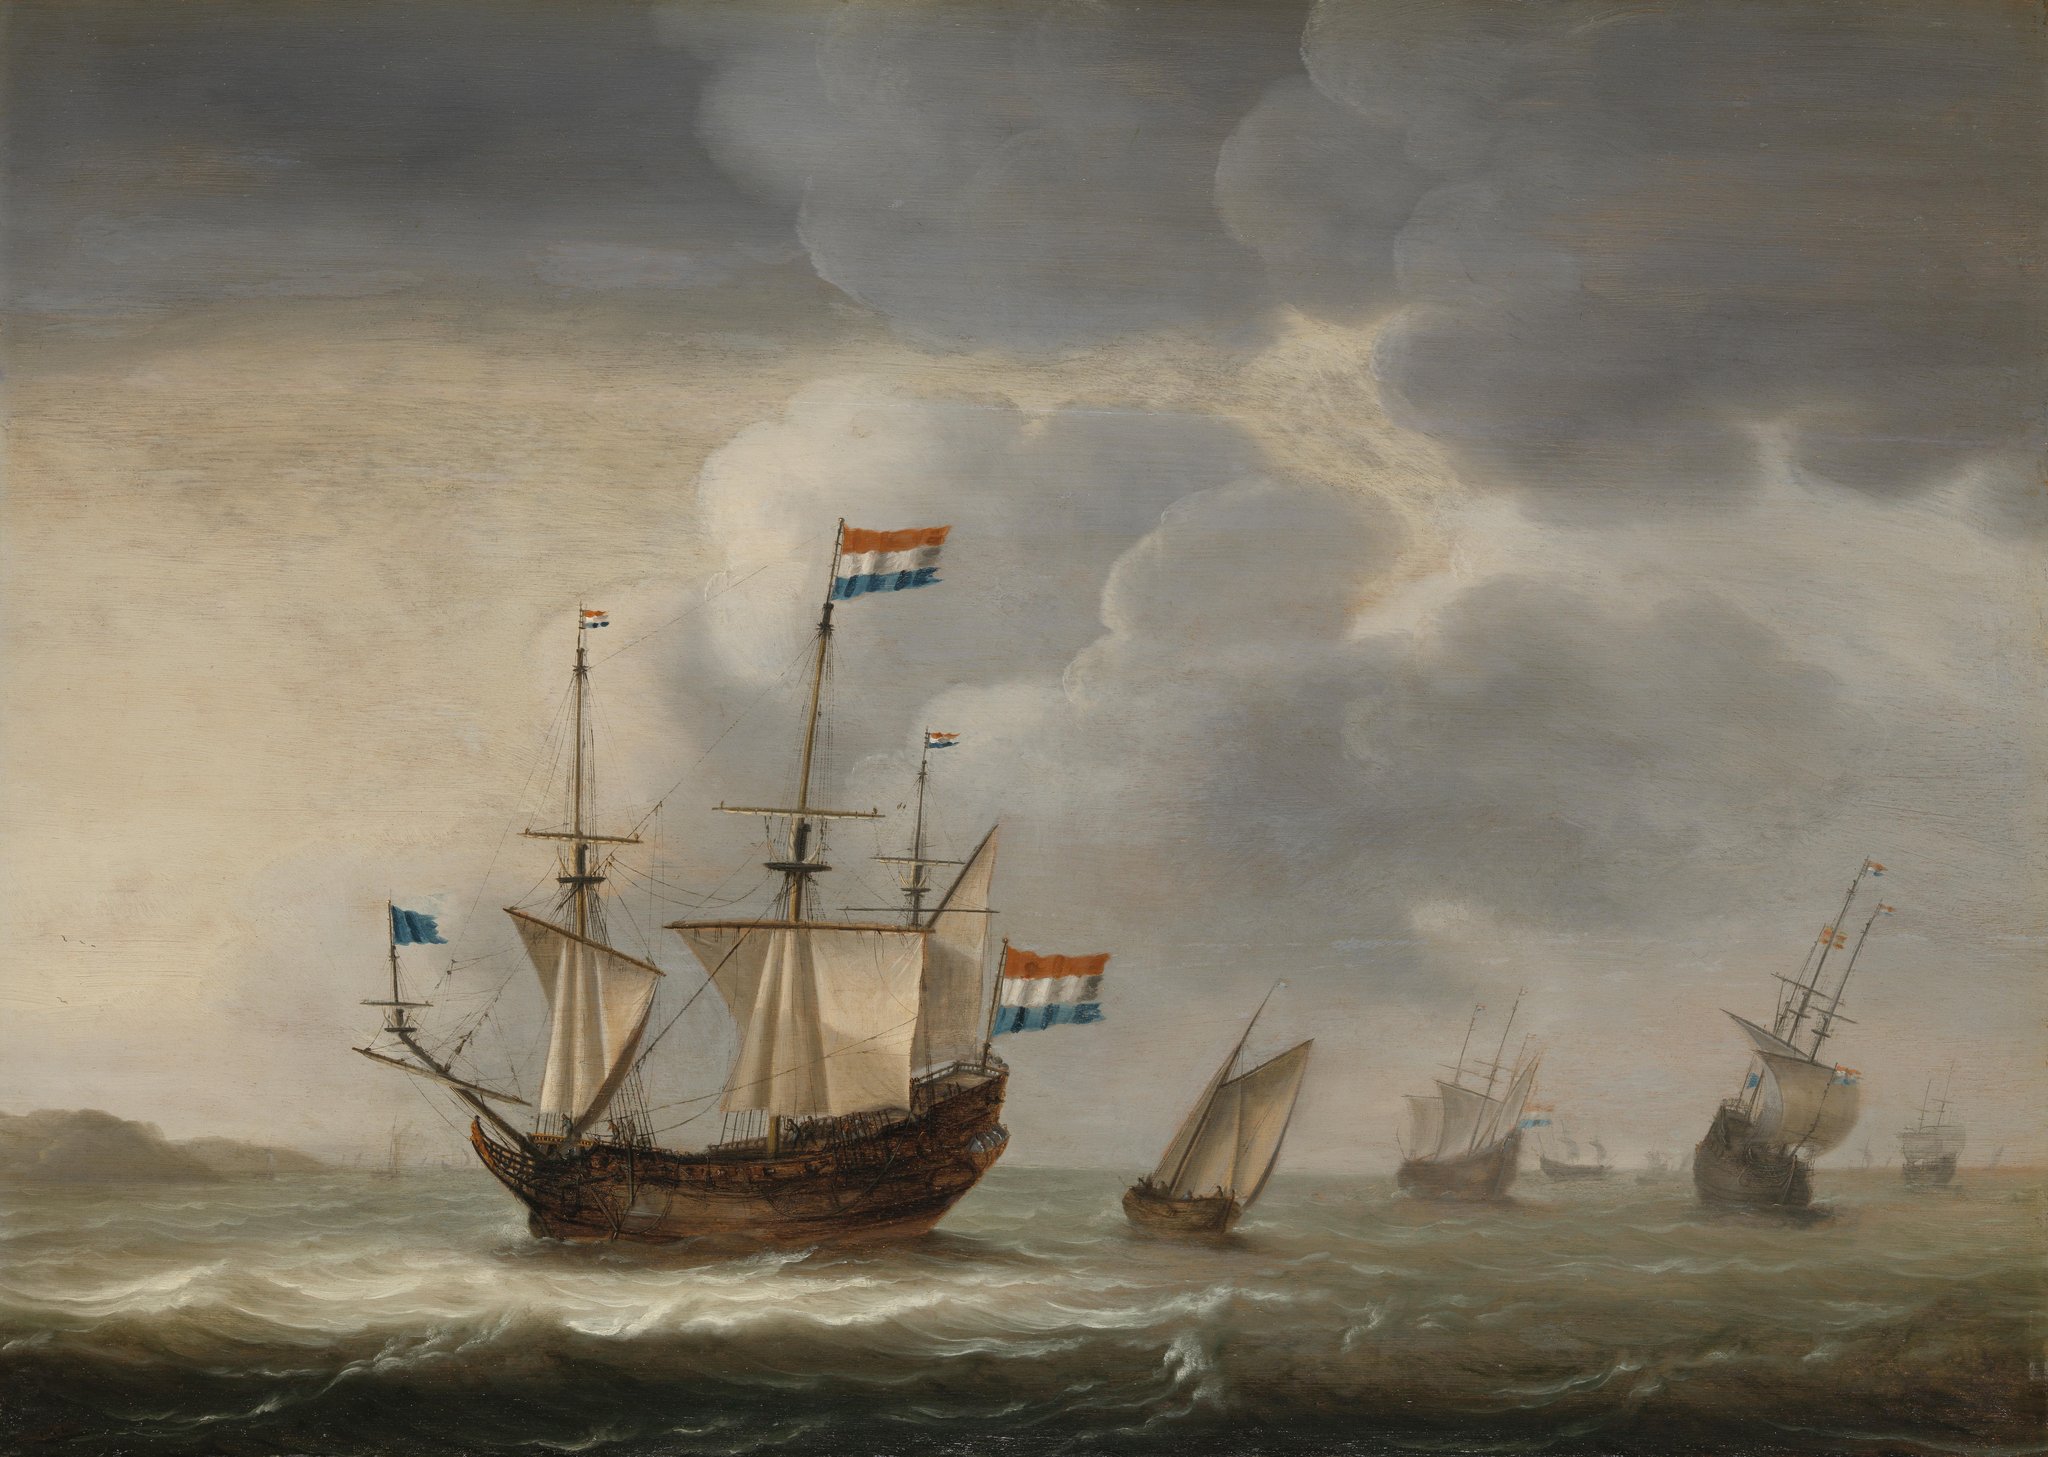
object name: painting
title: Ships off the Coast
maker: jacob gerritz loef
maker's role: painter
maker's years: 1606-1670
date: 1652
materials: oil, panel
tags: sailing-ship, sailing-boat, sea (seascape), coast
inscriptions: signature, with monogram, lower left, on a log: ‘I G L’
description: Schepen onder de kust. Zeegezicht met een oorlogsschip en enkele kleinere schepen.